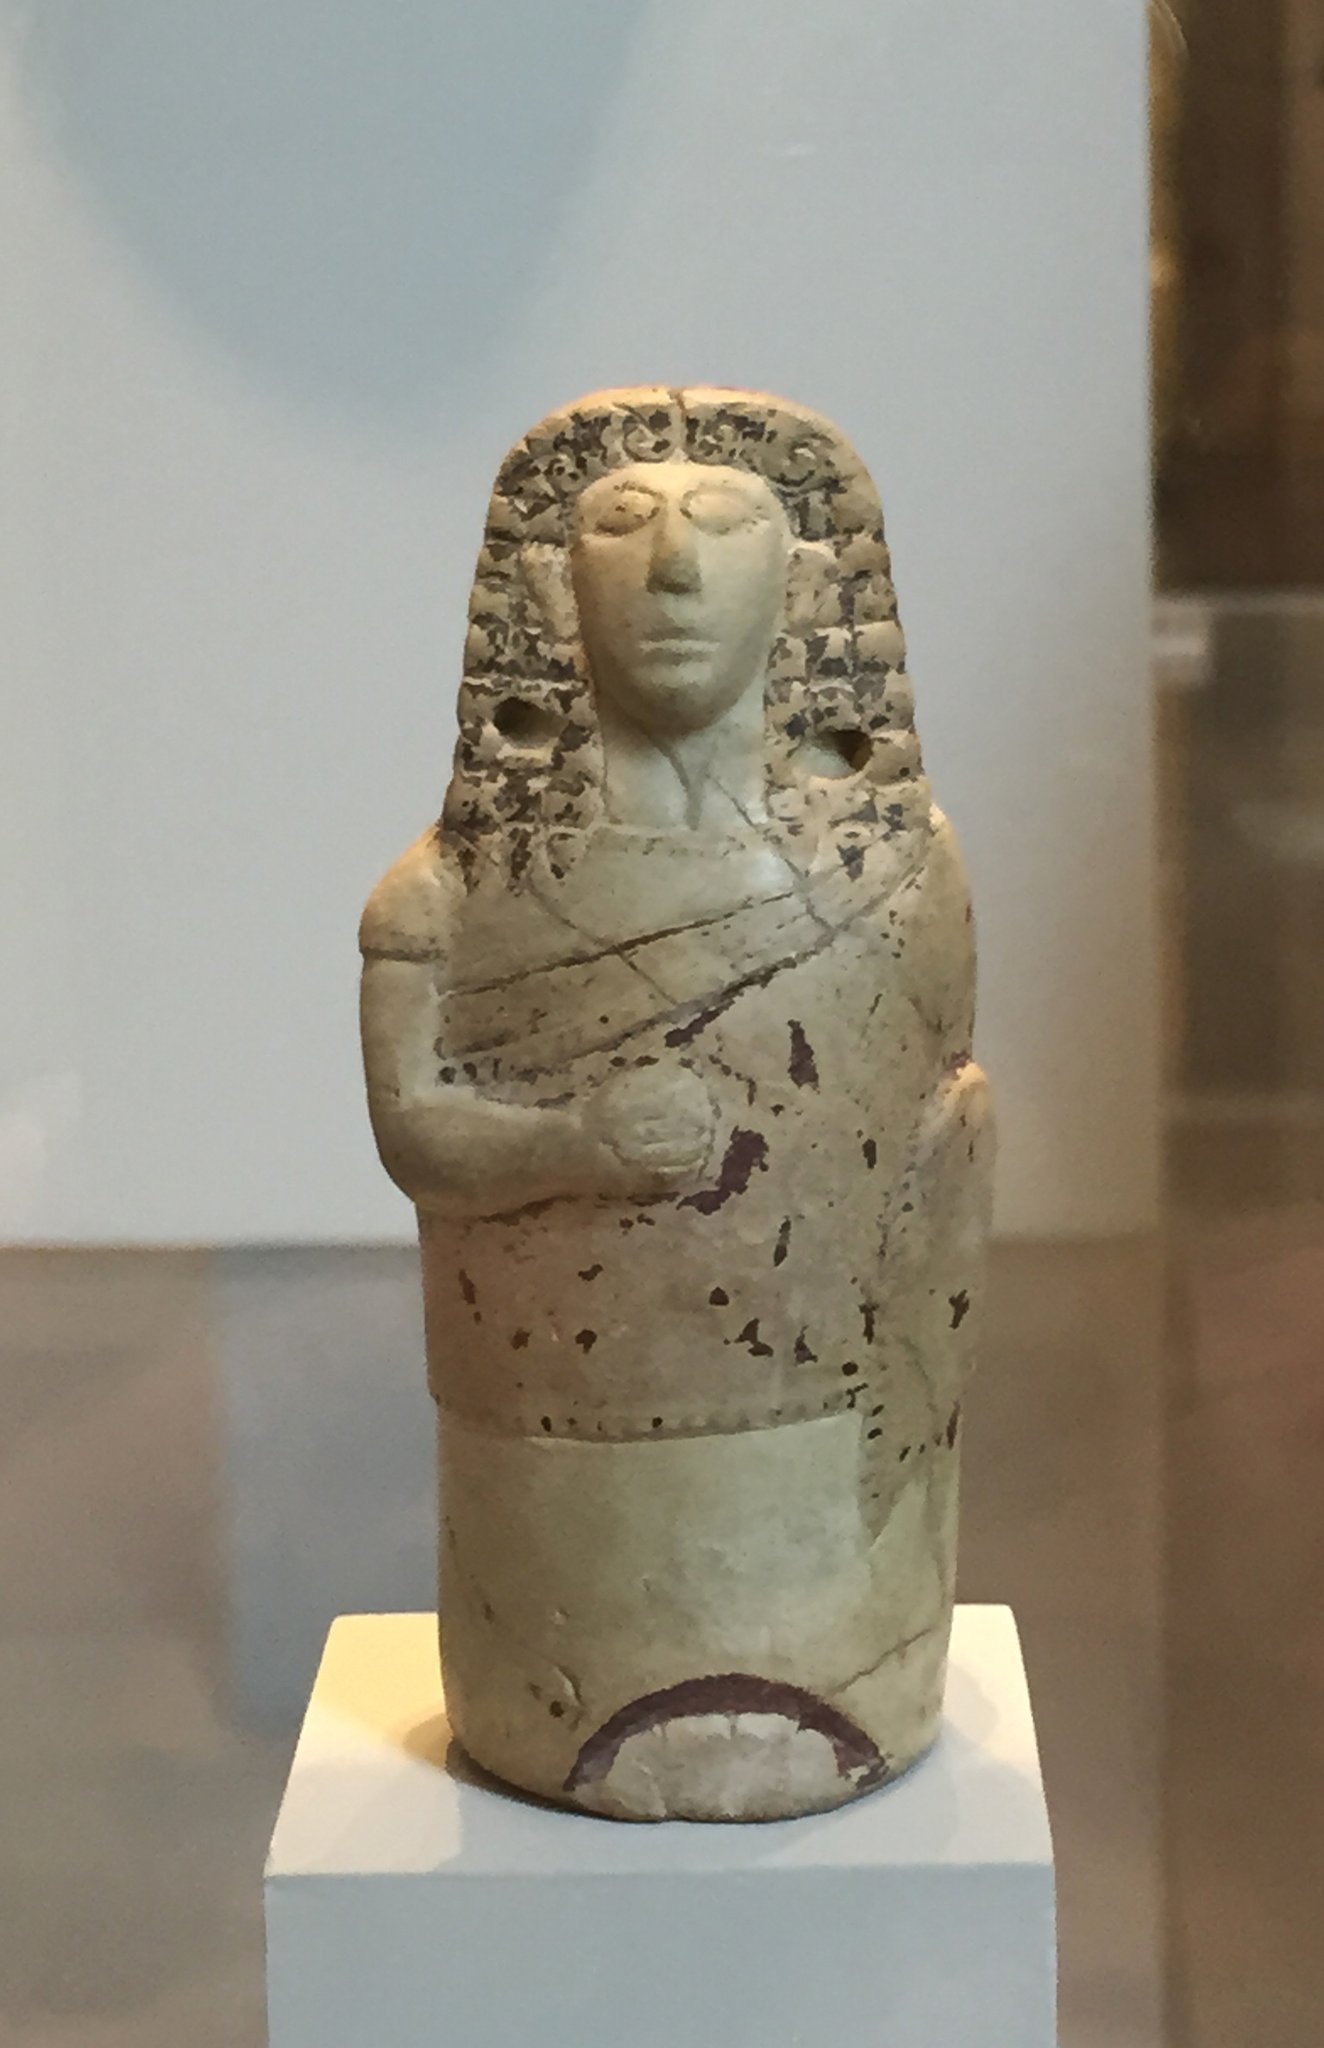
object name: aryballos in the form of a human figure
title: Terracotta aryballos (perfume vase) in the form of a human figure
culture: greek, corinthian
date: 640-625 BCE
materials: terracotta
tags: men